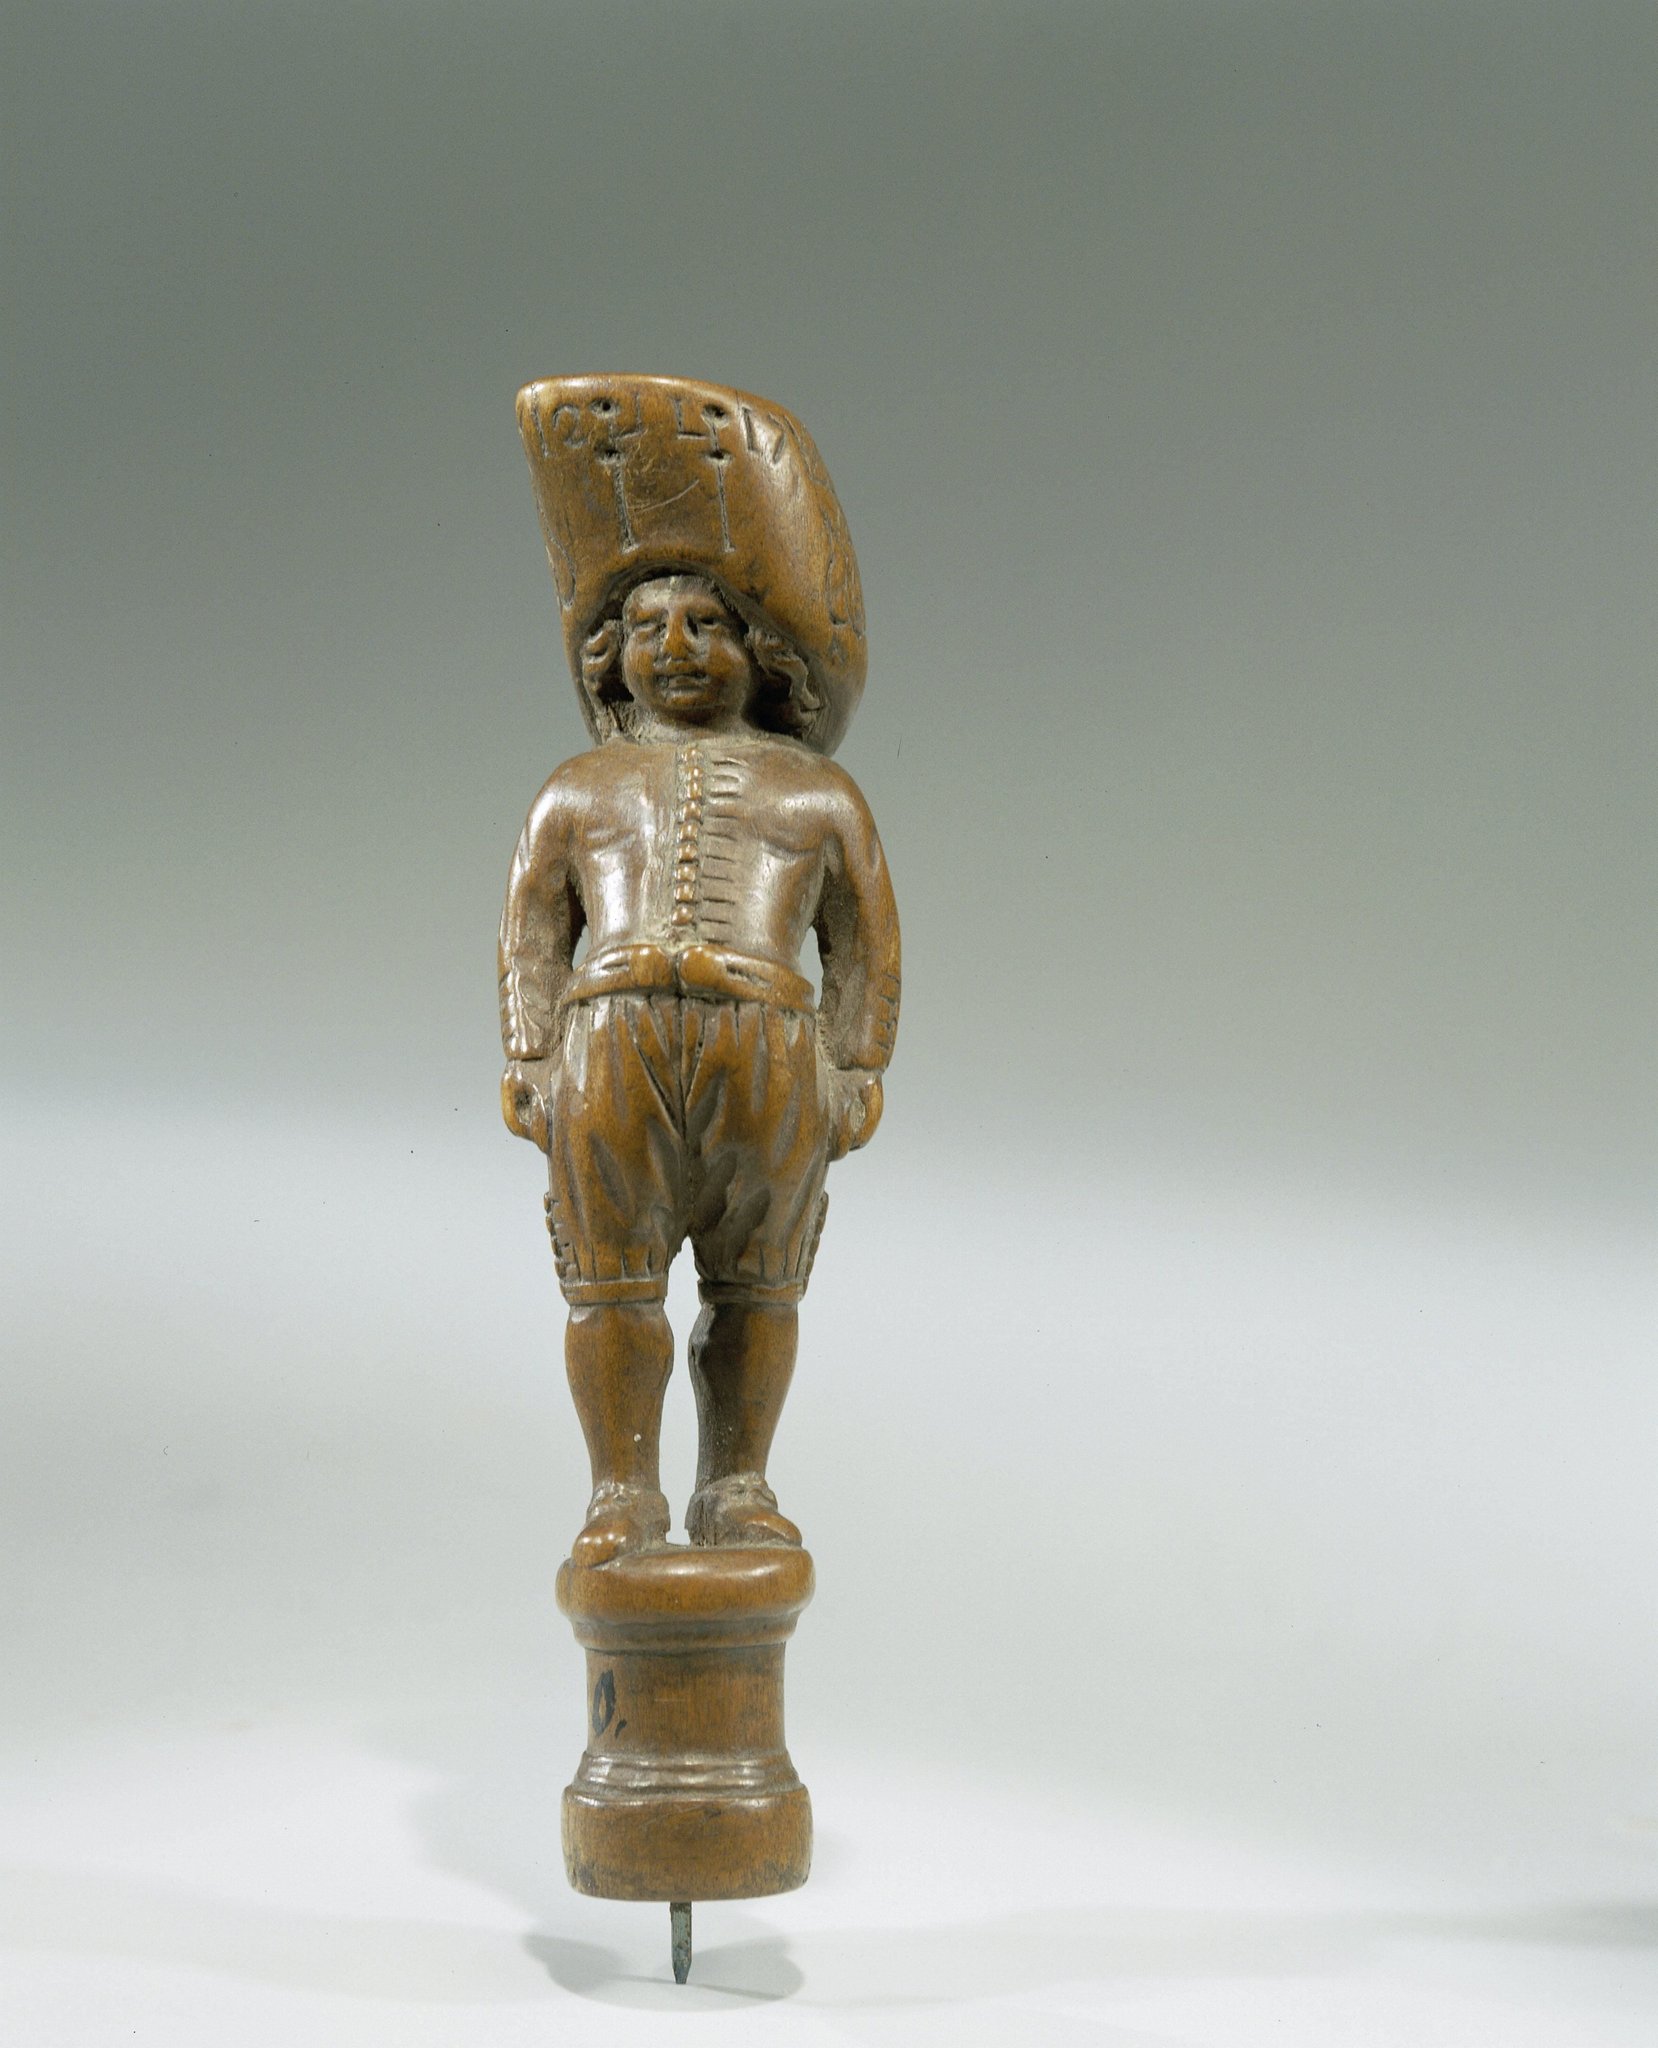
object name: sculpture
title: Corn-Carrier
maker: Anonymous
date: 1712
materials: wood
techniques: cutting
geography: northern netherlands